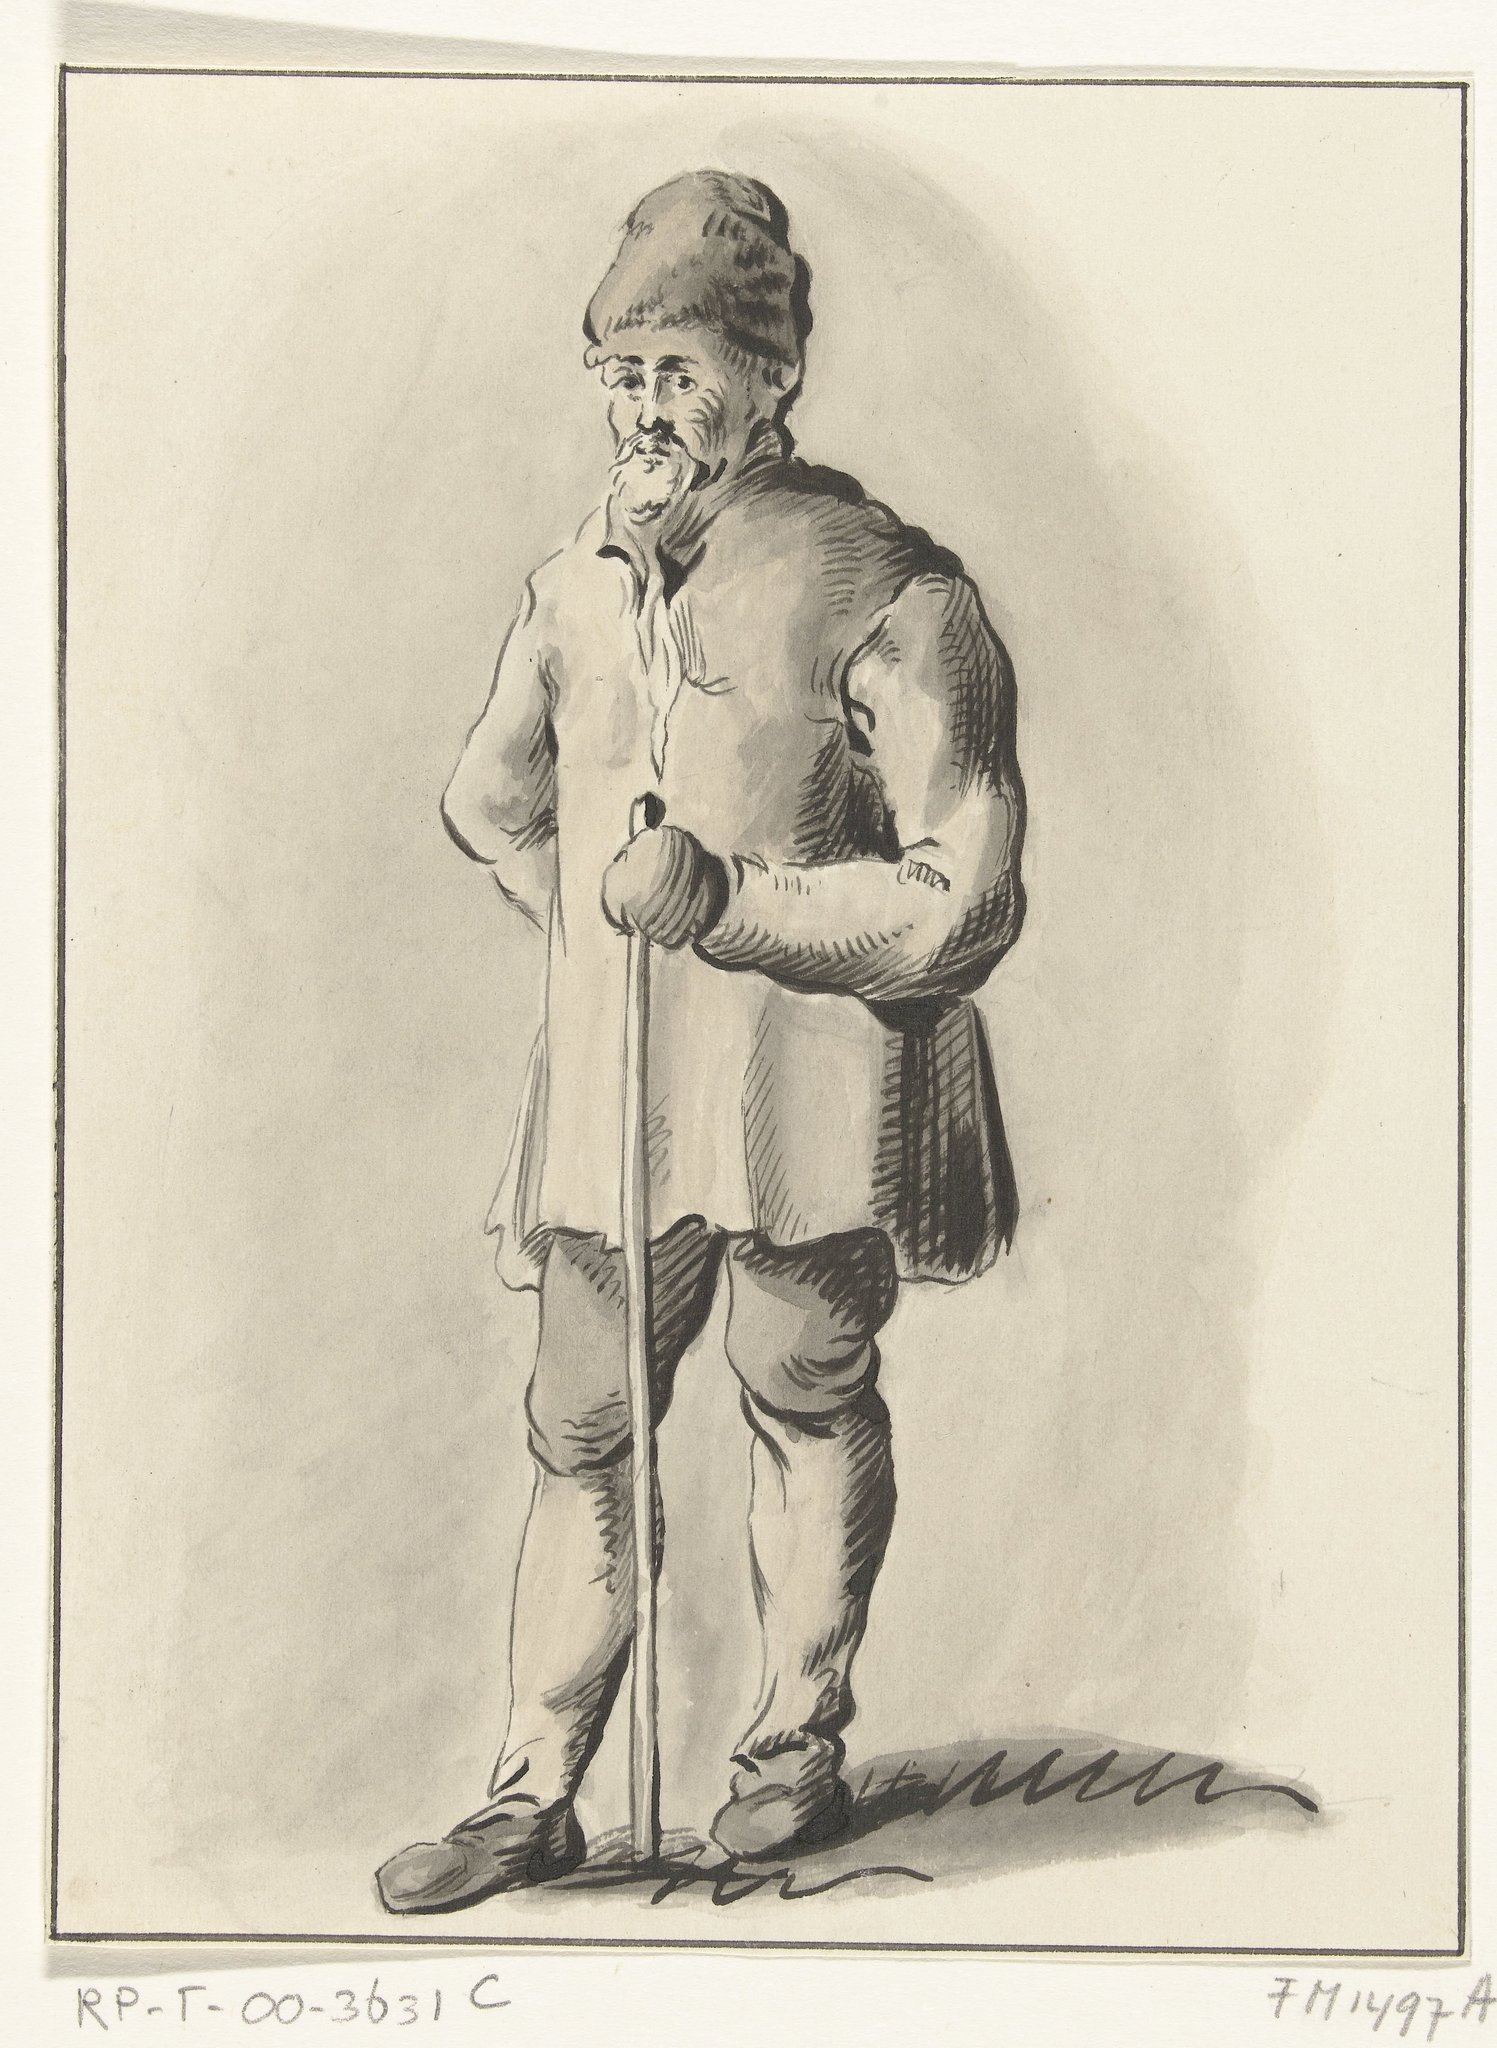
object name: historieplaat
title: Reinier van Oldenbarnevelt, heer van Groeneveld, 1623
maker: j.c. wendel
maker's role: draughtsman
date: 1850-1870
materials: paper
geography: netherlands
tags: maurice (prince of orange), arrest (of criminal)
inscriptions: inscription: ‘Reinier van Barneveldt zoals hij in Den Haag is gebracht 19 Febr. 1623’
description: Reinier van Oldenbarnevelt, de samenzweerder tegen Maurits in 1623, staande met een stok in de hand. Afgebeeld zoals hij als gevangene naar Den Haag is gebracht, 19 februari 1623.